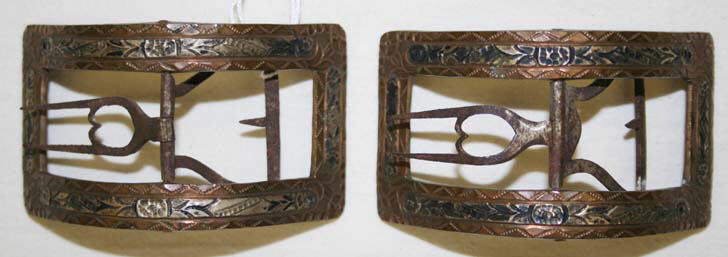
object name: shoe buckle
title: Shoe buckles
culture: european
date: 1801-1833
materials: metal